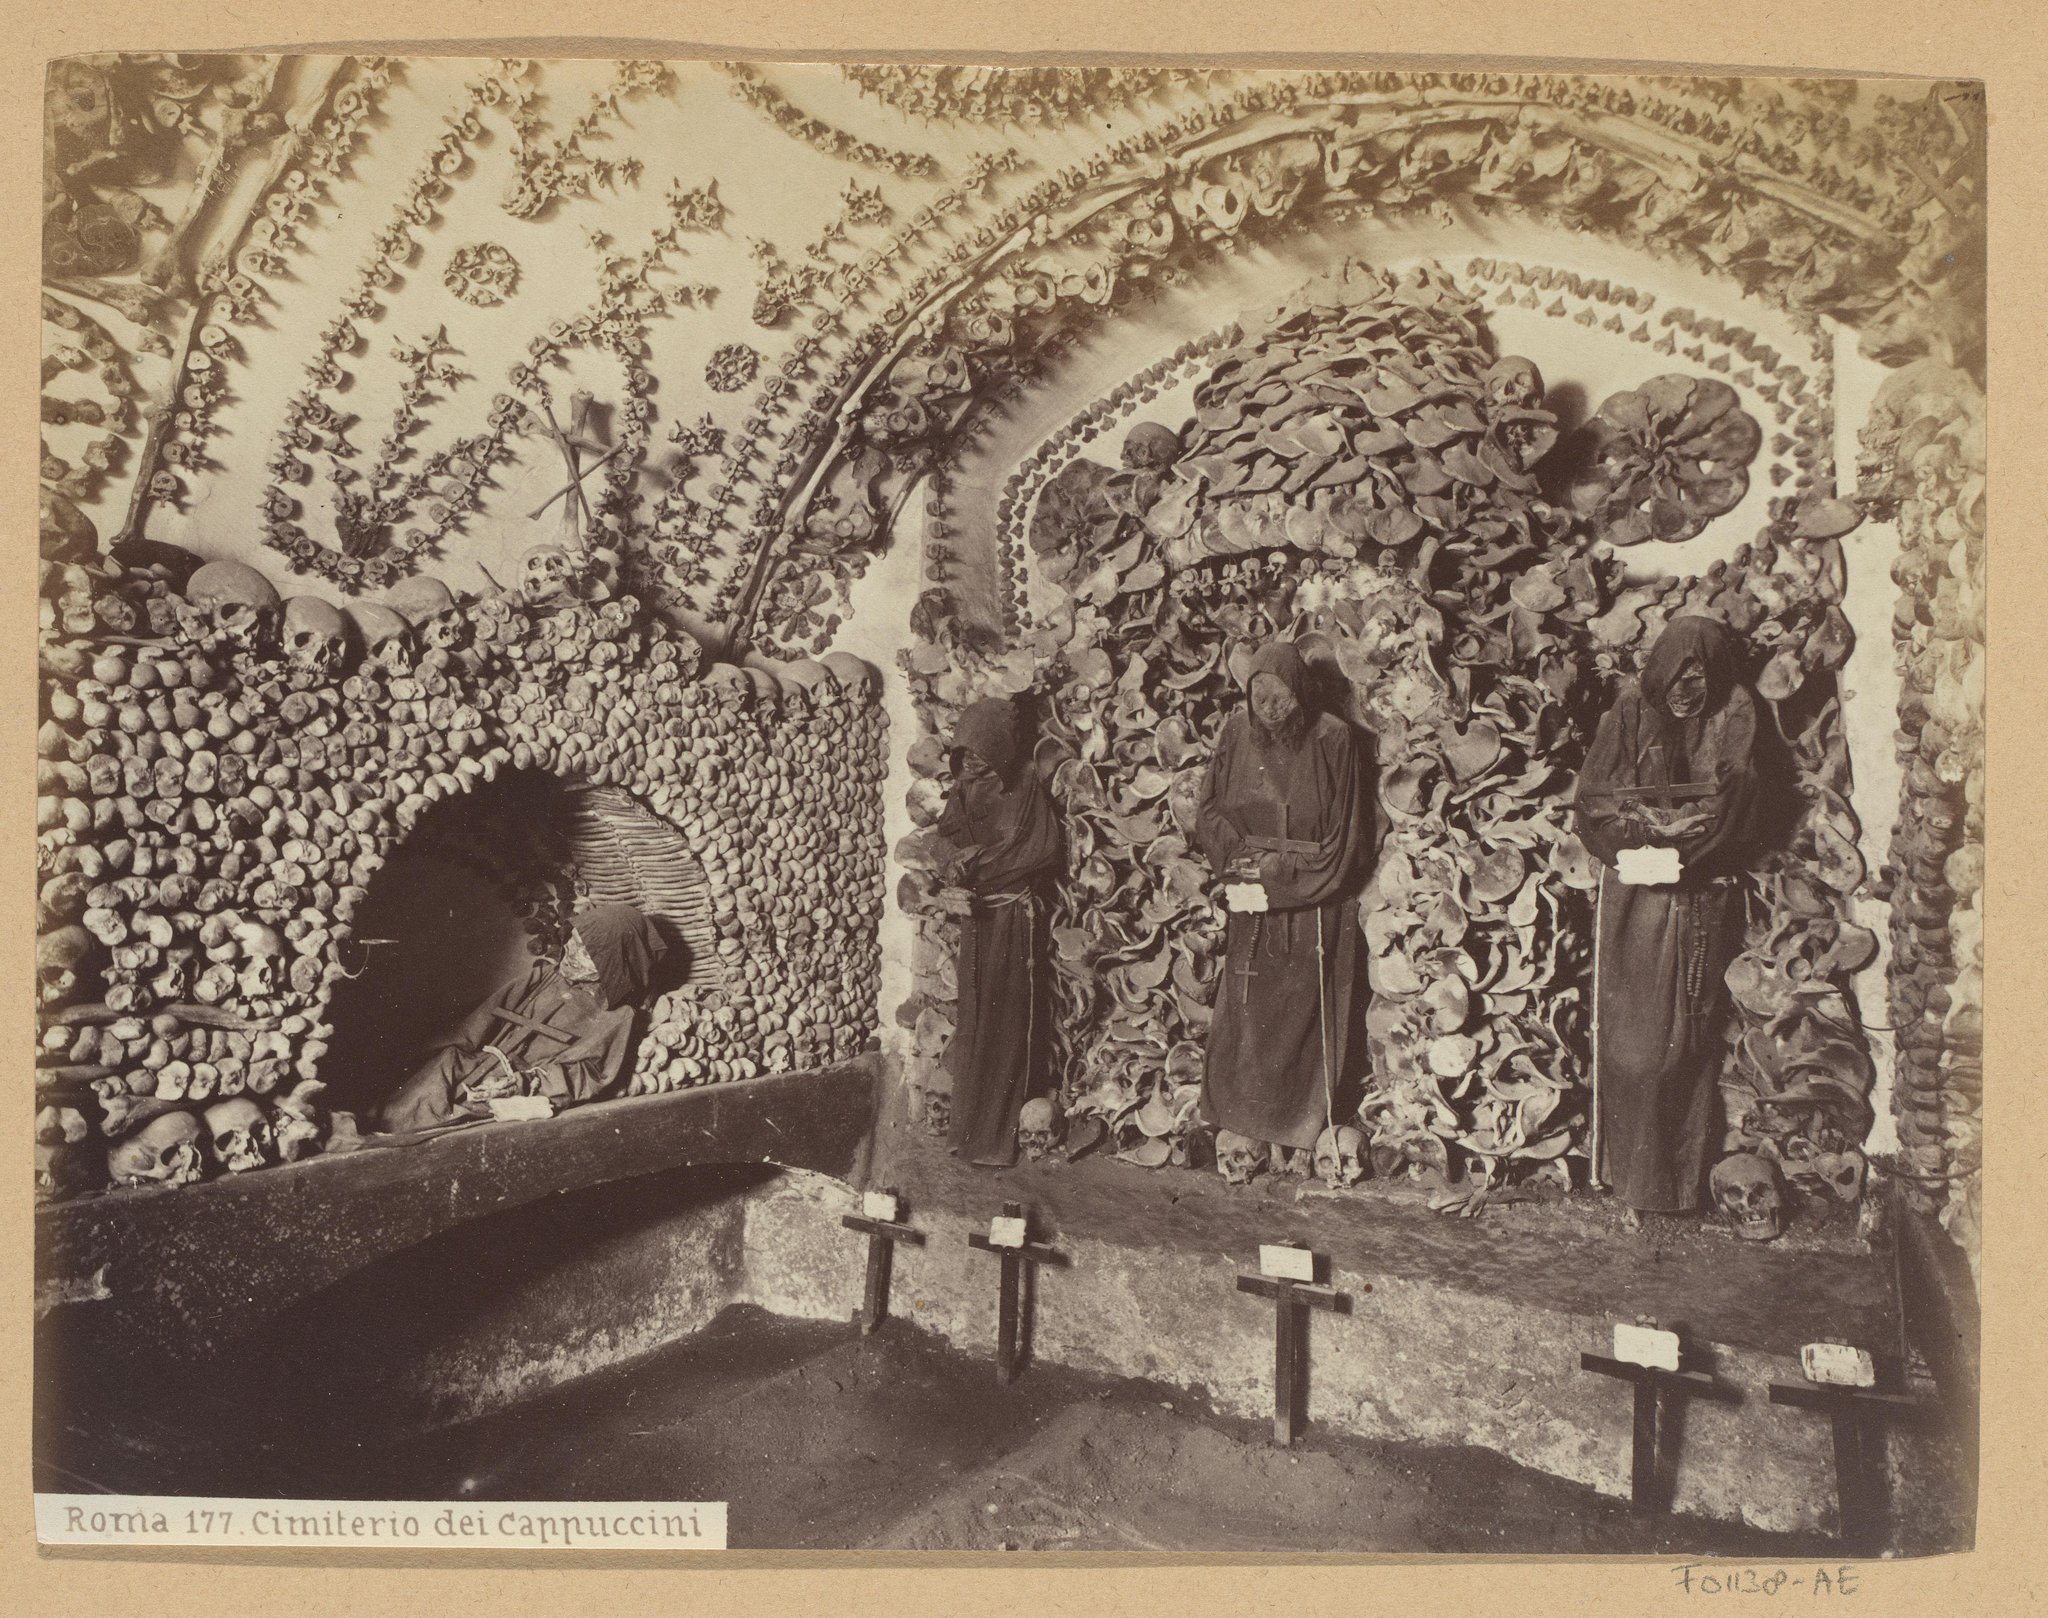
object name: photograph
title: Grafkelder in de Chiesa di Santa Maria della Concezione dei Cappuccini in Roma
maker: Anonymous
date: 1860-1900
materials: photographic support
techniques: albumen print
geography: santa maria della concezione dei cappuccini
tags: charnelhouse, ossuary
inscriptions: number: ‘177’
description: Onderdeel van Reisalbum met opnames van kunstwerken en bezienswaardigheden in Italië, Griekenland en Frankrijk.